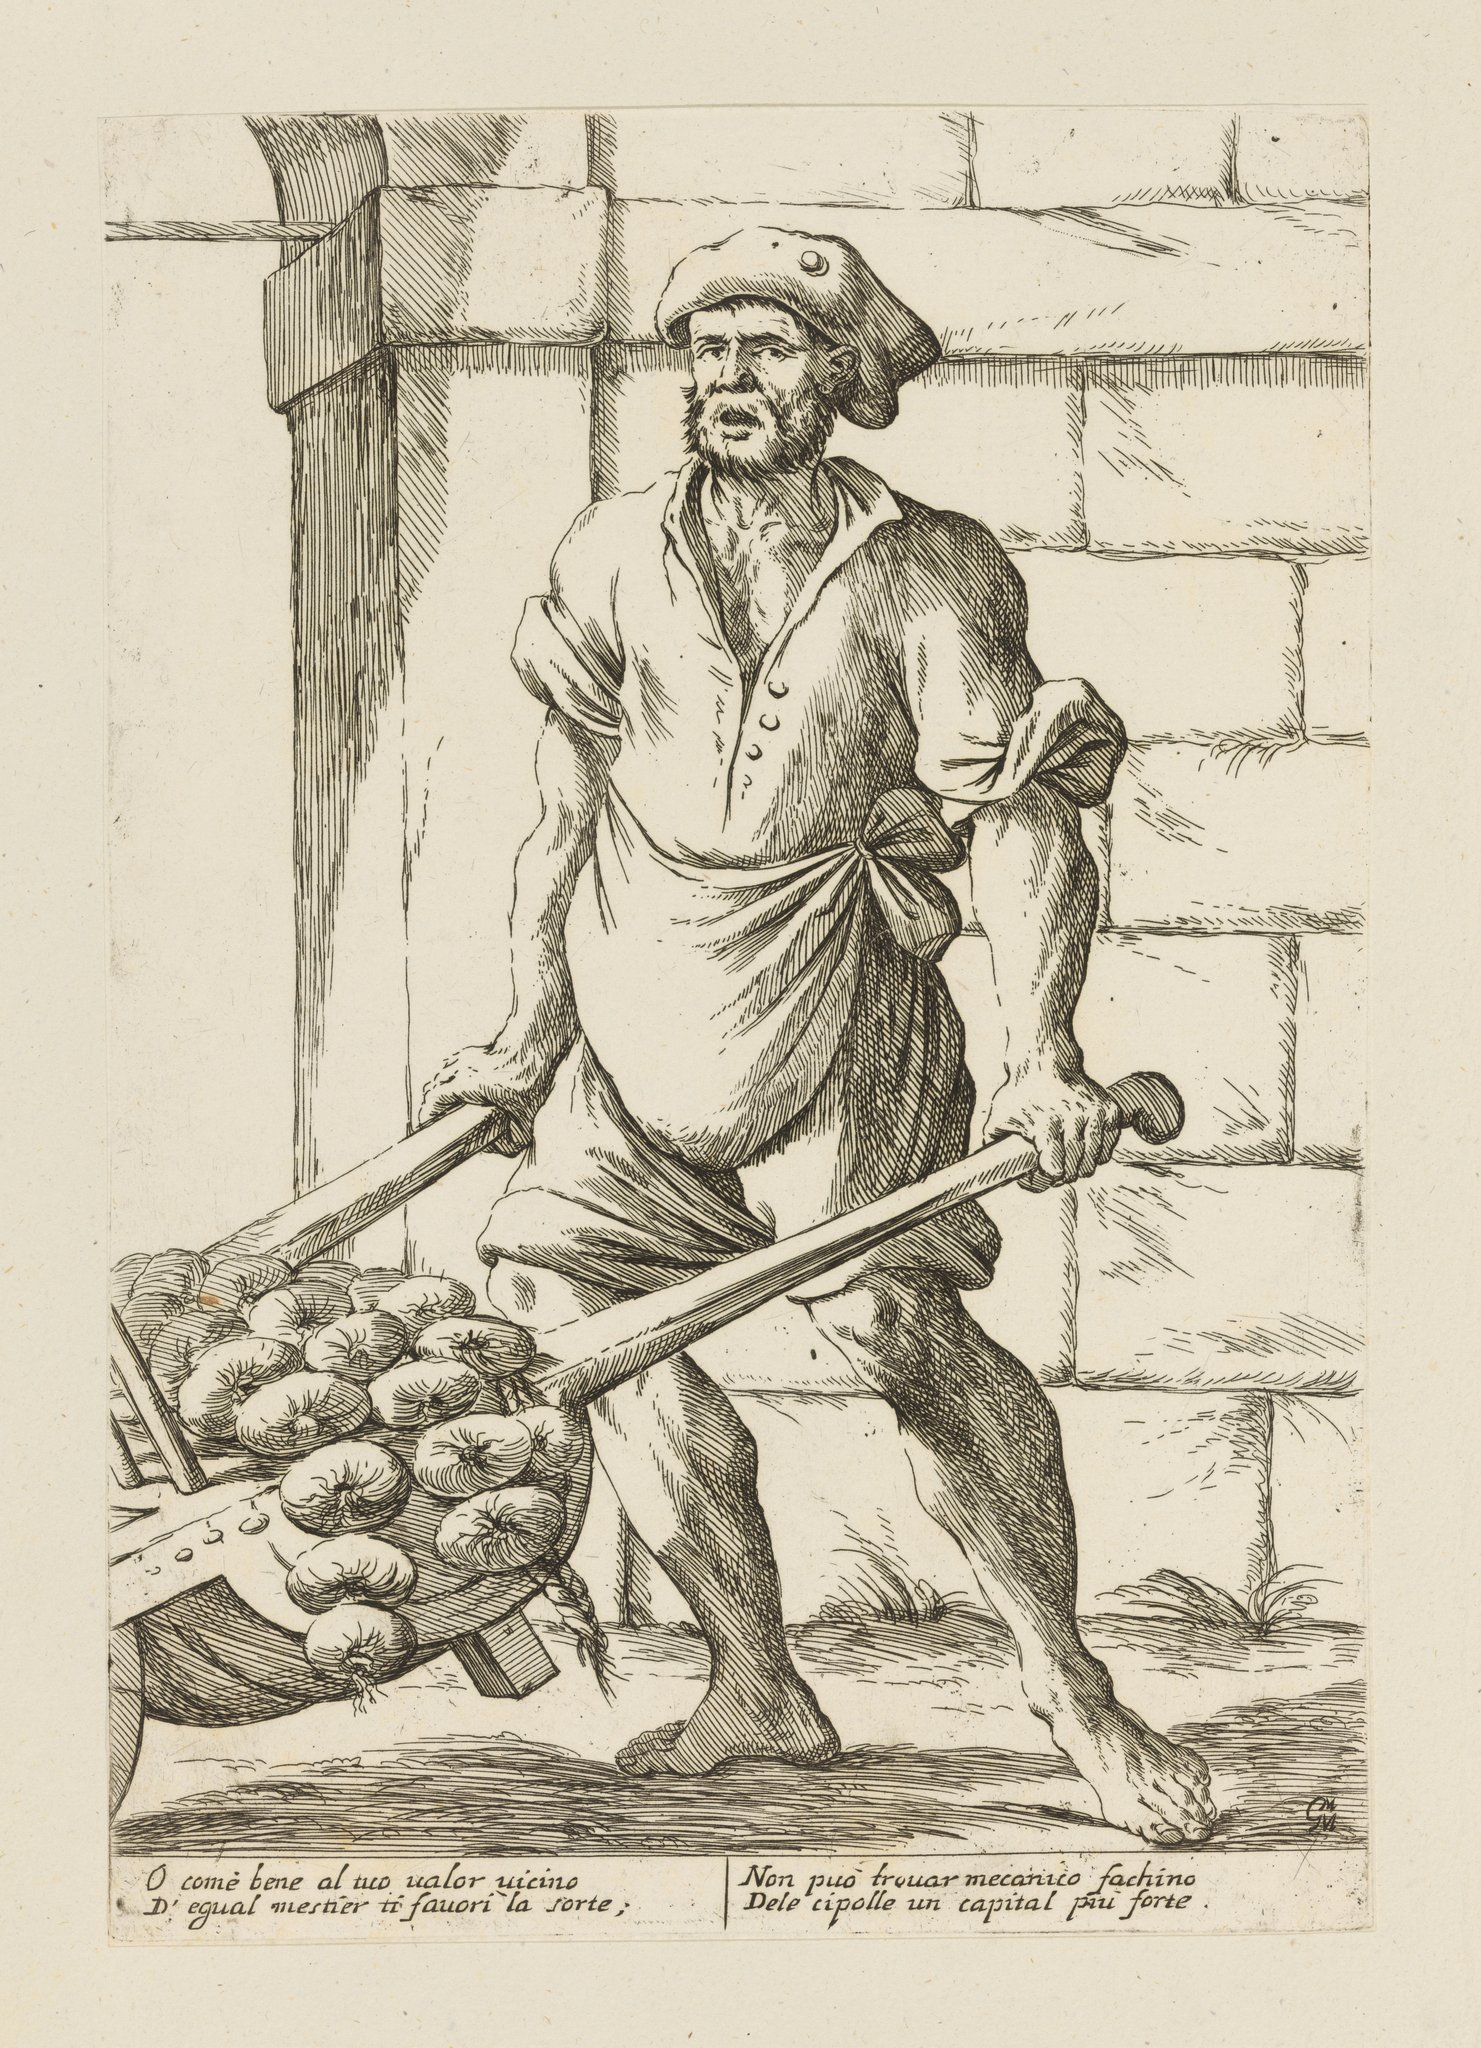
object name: print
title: Onion Seller, from Di Bologna l'Arti per via D'An.ibal' Ca.rac, plate 28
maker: giuseppe maria mitelli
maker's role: artist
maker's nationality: italian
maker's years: 1634-1718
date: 1660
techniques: etching